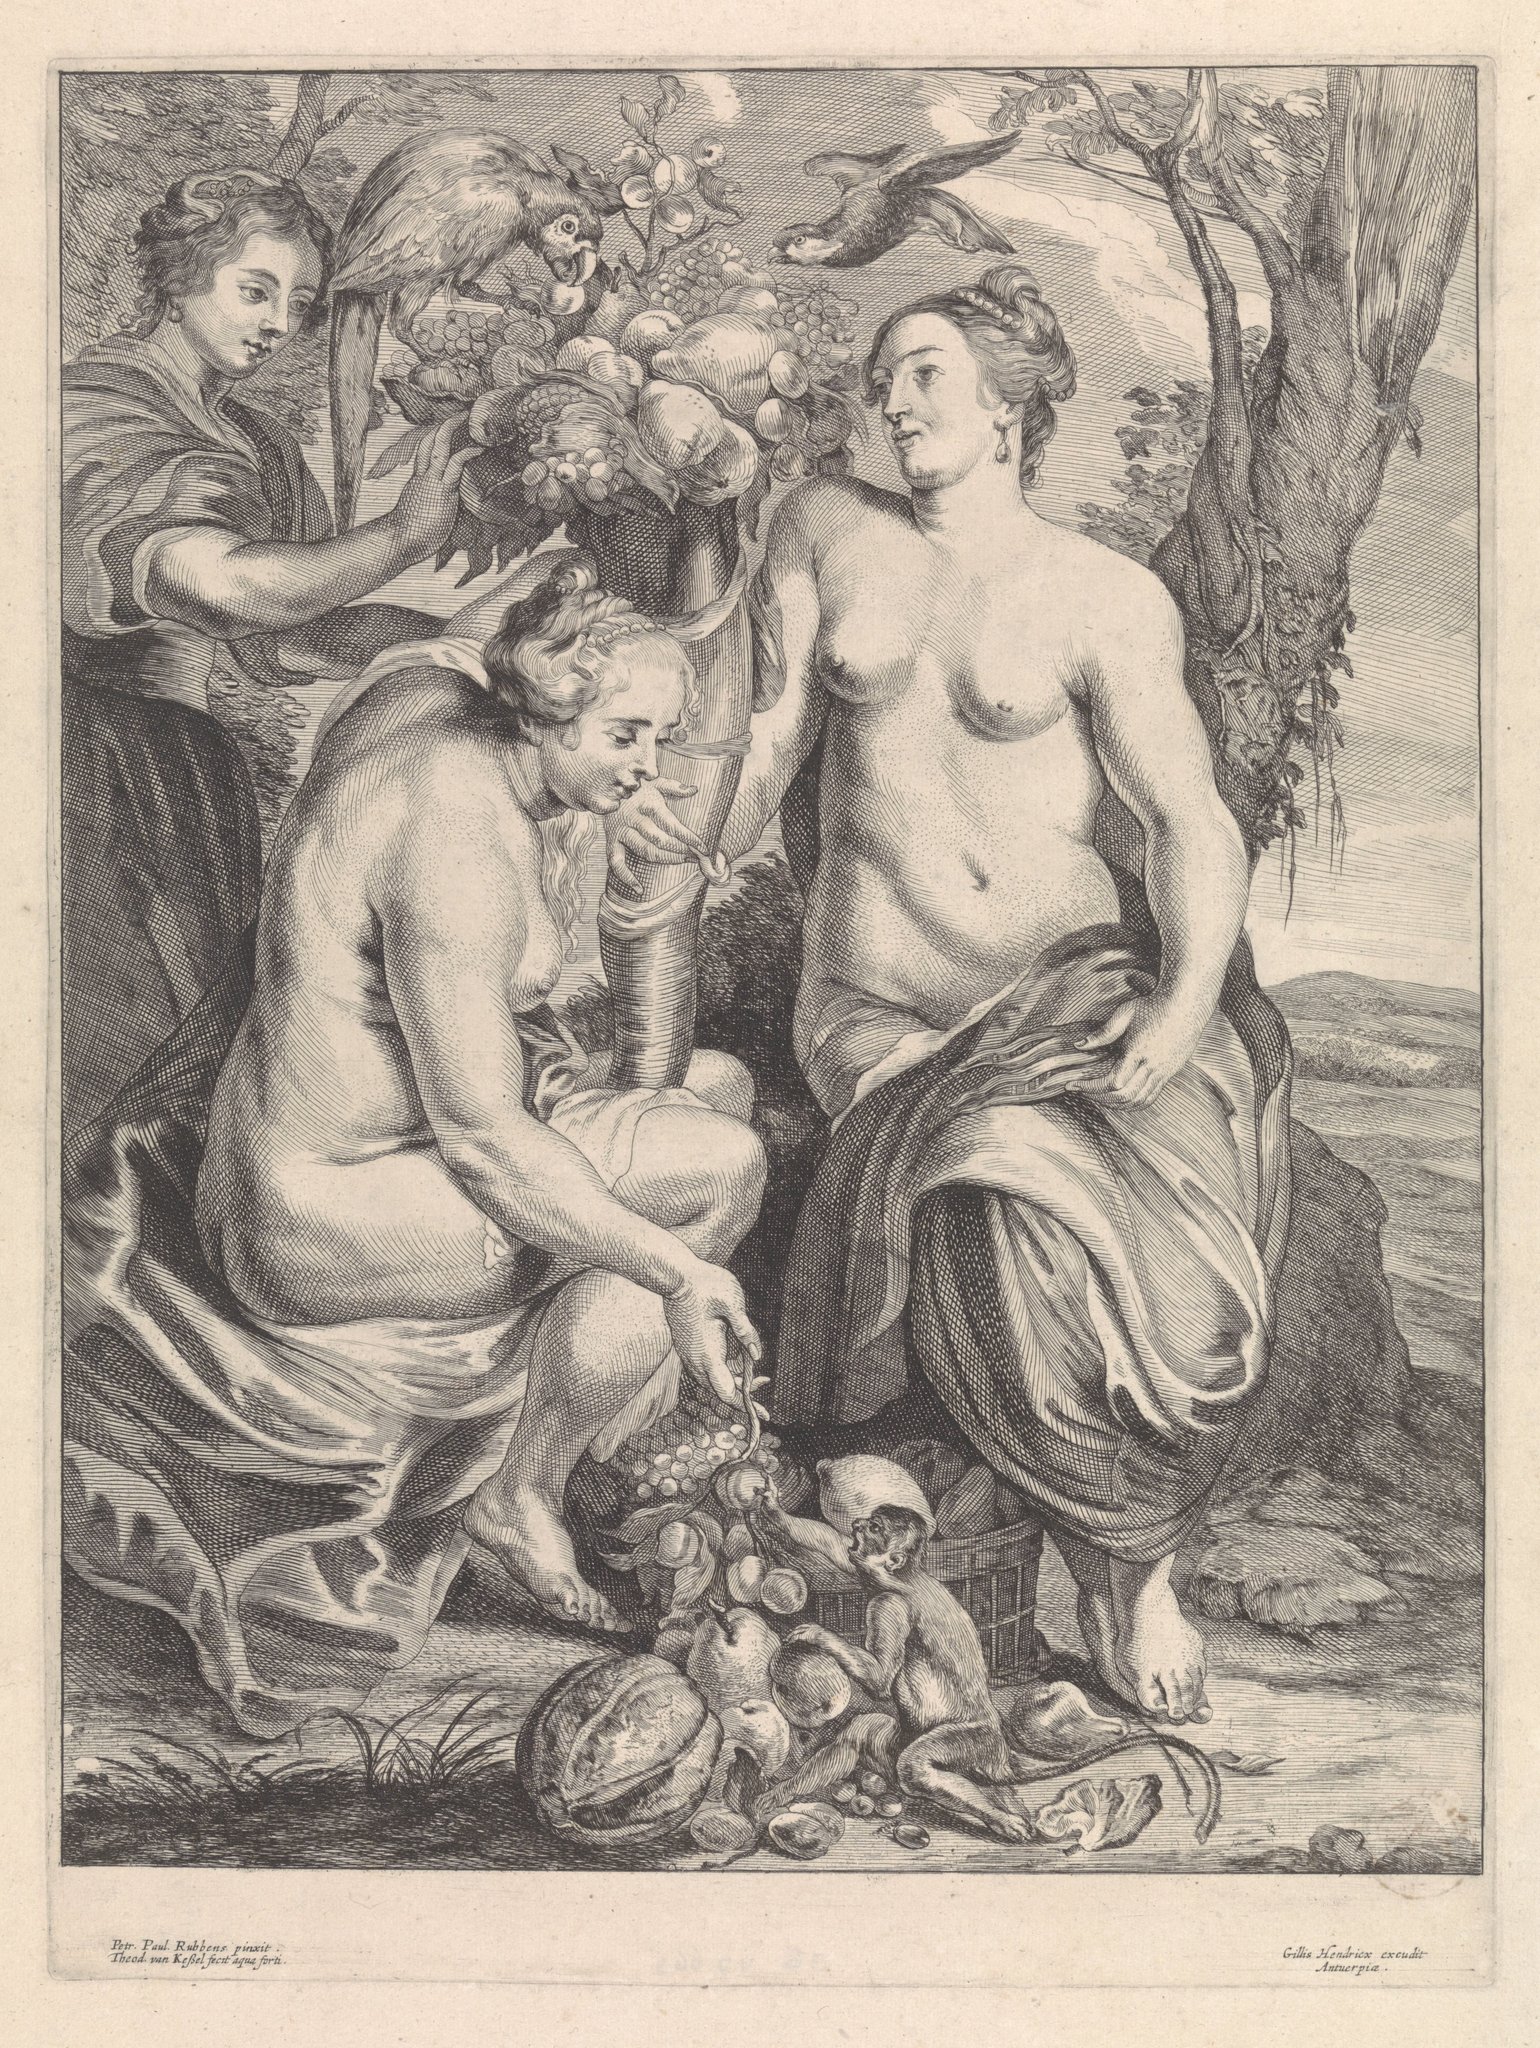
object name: print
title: De hoorn des overvloeds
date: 1630-1660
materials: paper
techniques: engraving, etching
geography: antwerp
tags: 'cornucopia', horn of plenty, adult woman, ornamental birds, monkeys, apes, other types of nymph(s)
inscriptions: collector's mark: Lugt 240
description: In een landschap onder de bomen bevinden zich twee nimfen en een jonge vrouw bij de hoorn des overvloeds. Op de grond zit een aapje die van een van de nimfen een tak met abrikozen aangereikt krijgt en op het fruit dat uit de hoorn puilt zit een papegaai.